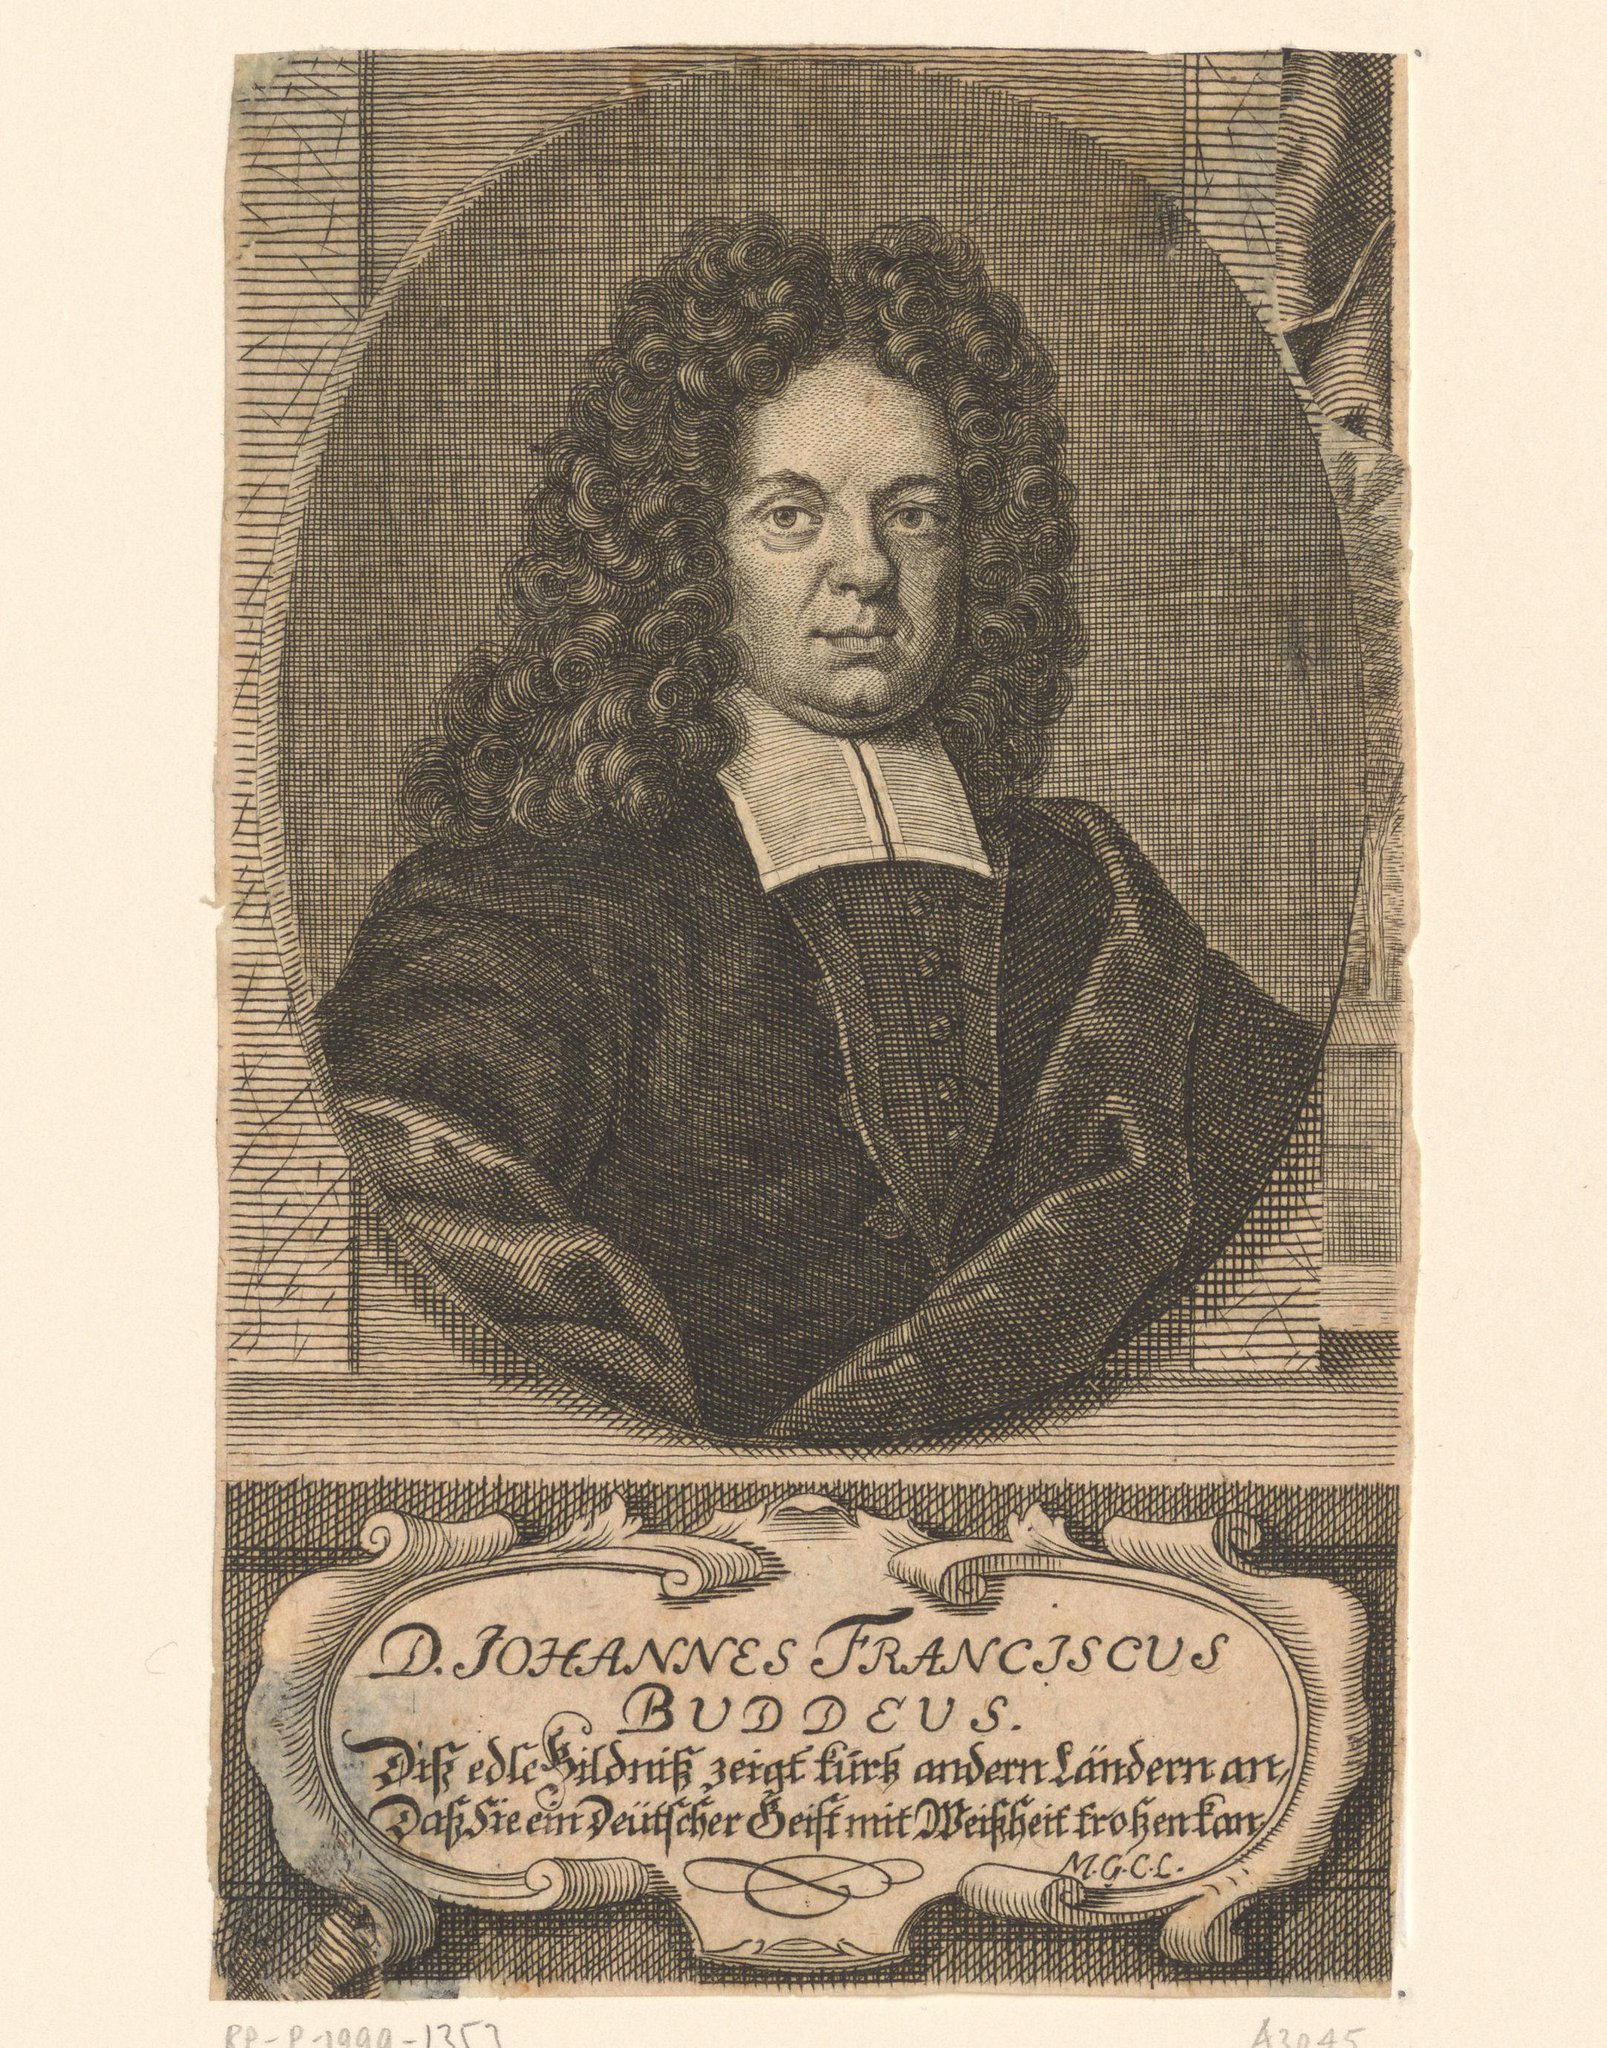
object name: print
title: Portret van Johann Franz Buddeus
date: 1700-1749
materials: paper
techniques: engraving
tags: theologian, historical persons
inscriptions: collector's mark: Lugt 2228